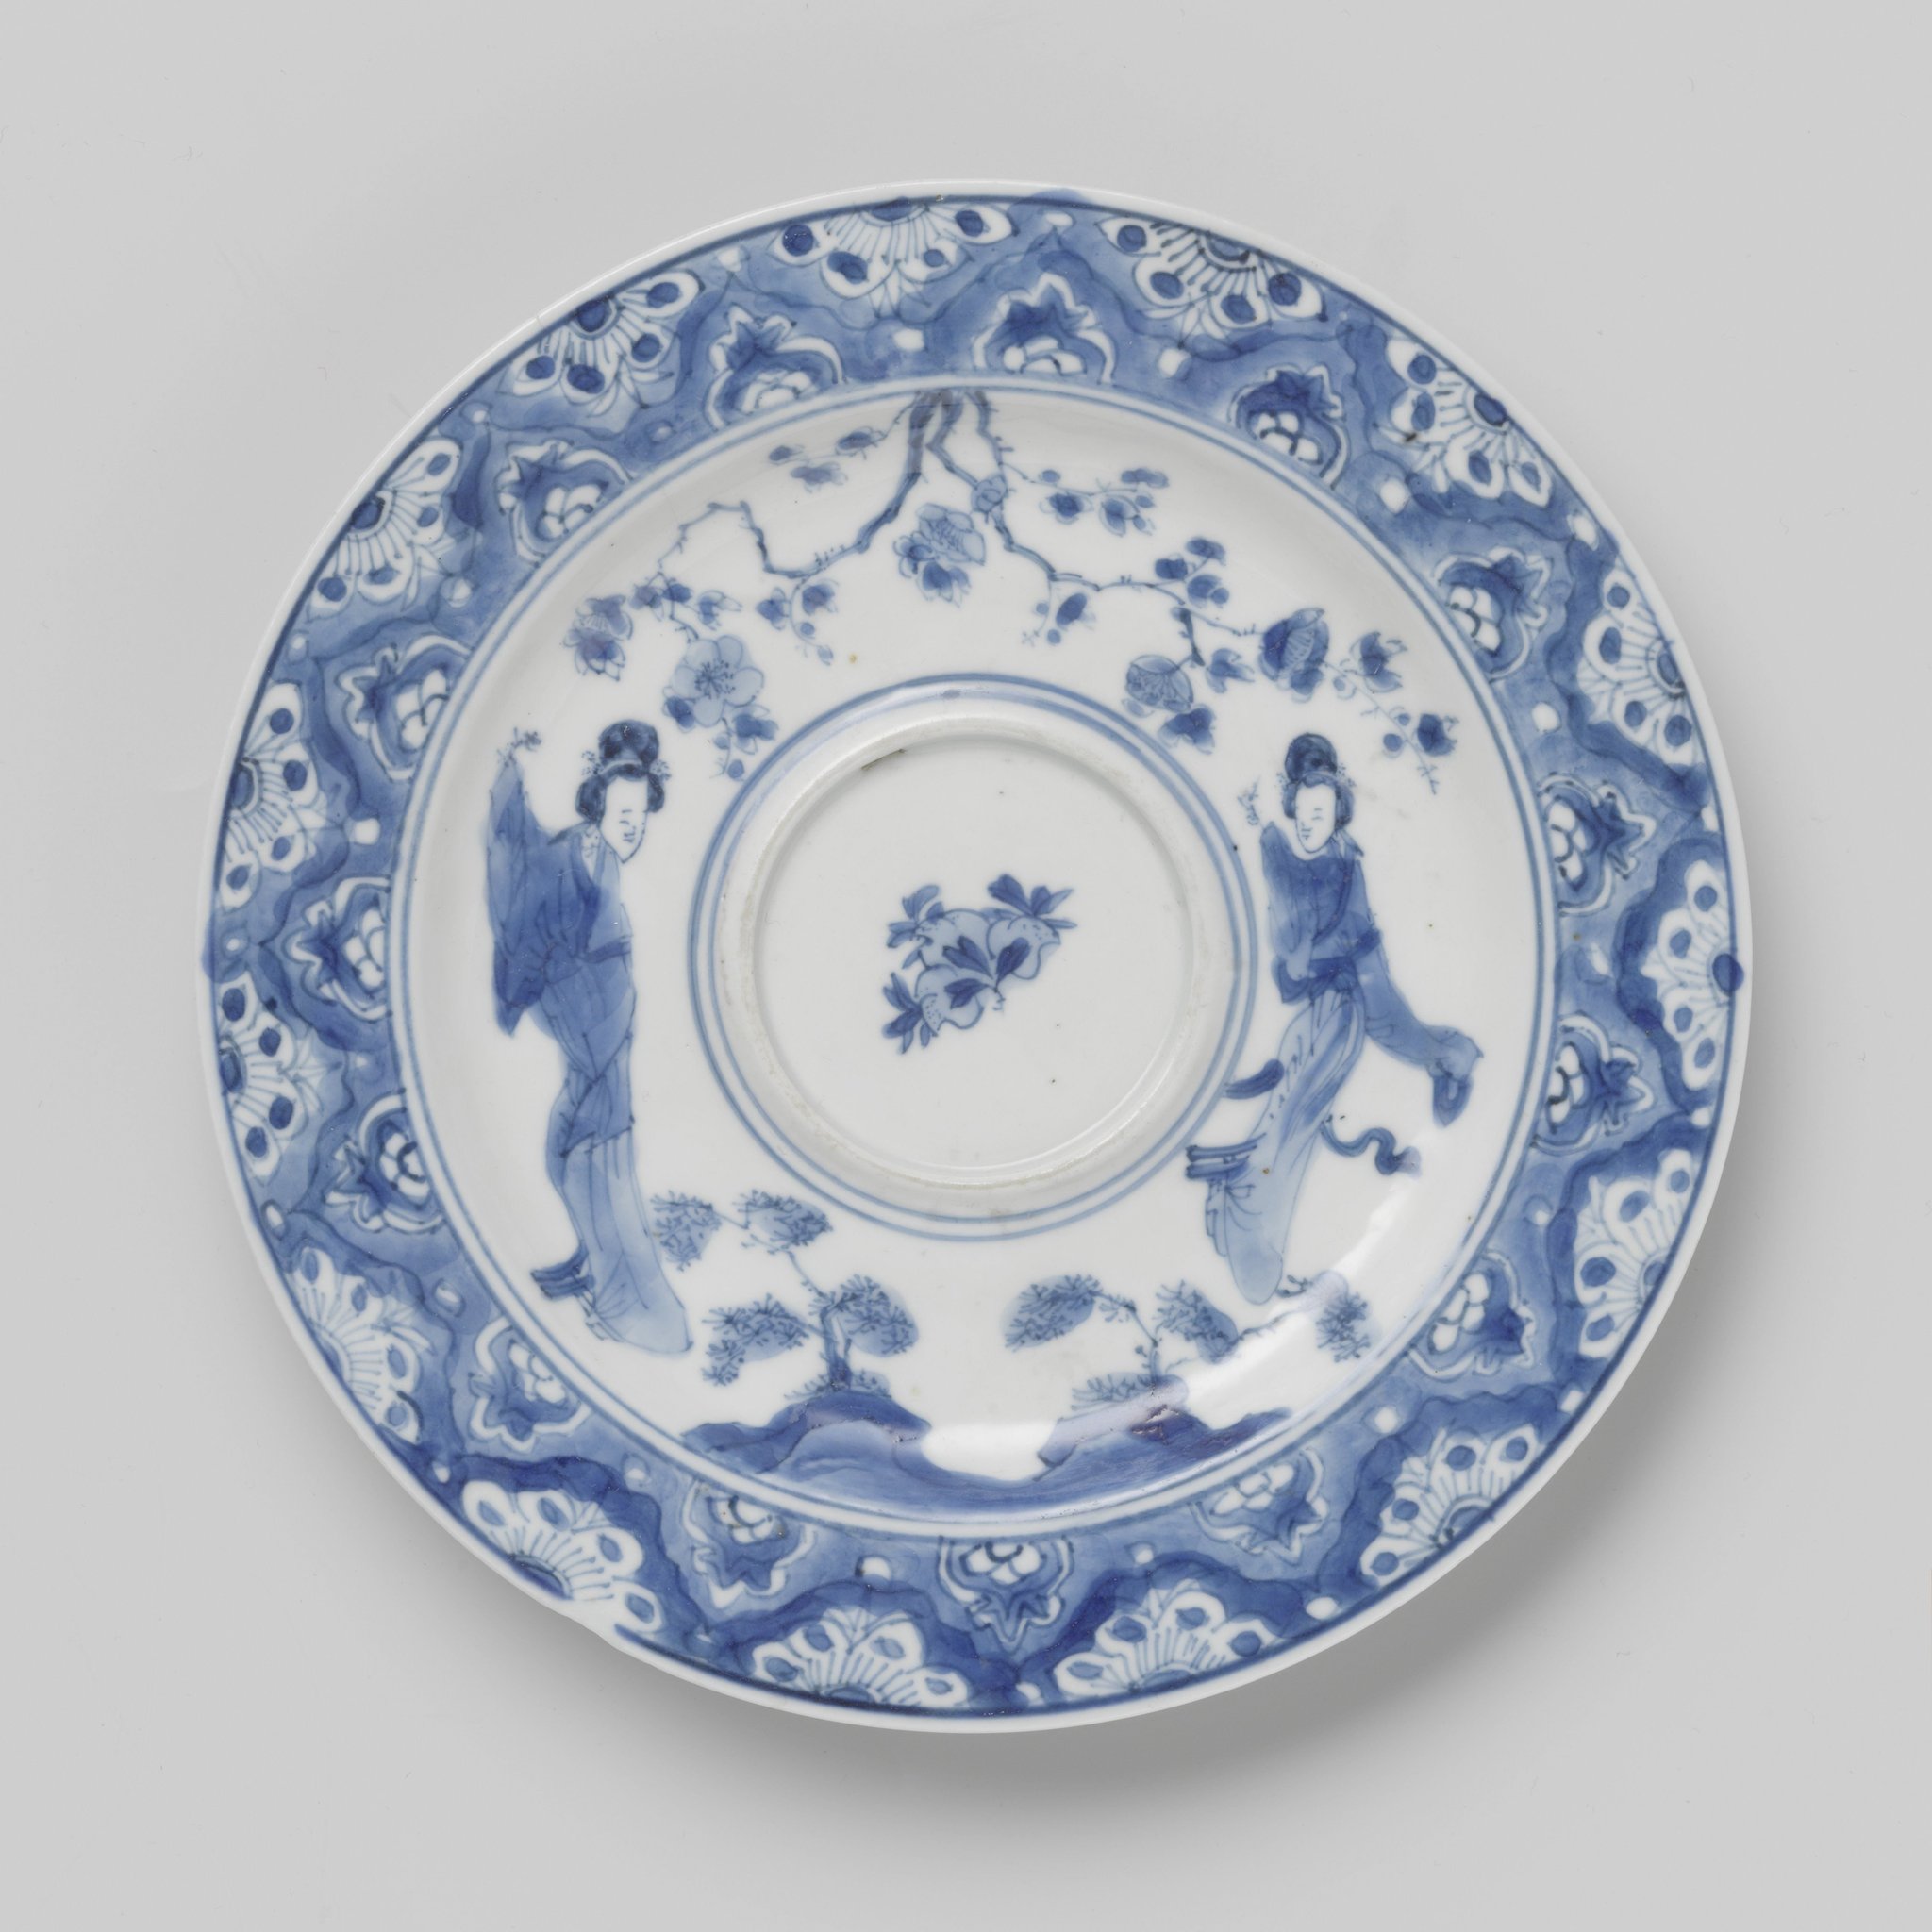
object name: plate dish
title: Plate with two women and prunus spray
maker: Anonymous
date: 1680-1720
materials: cobalt, glaze, paint, porcelain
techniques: firing, turning, vitrification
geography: china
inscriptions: mark: ‘大 清 康 熙 年 製’